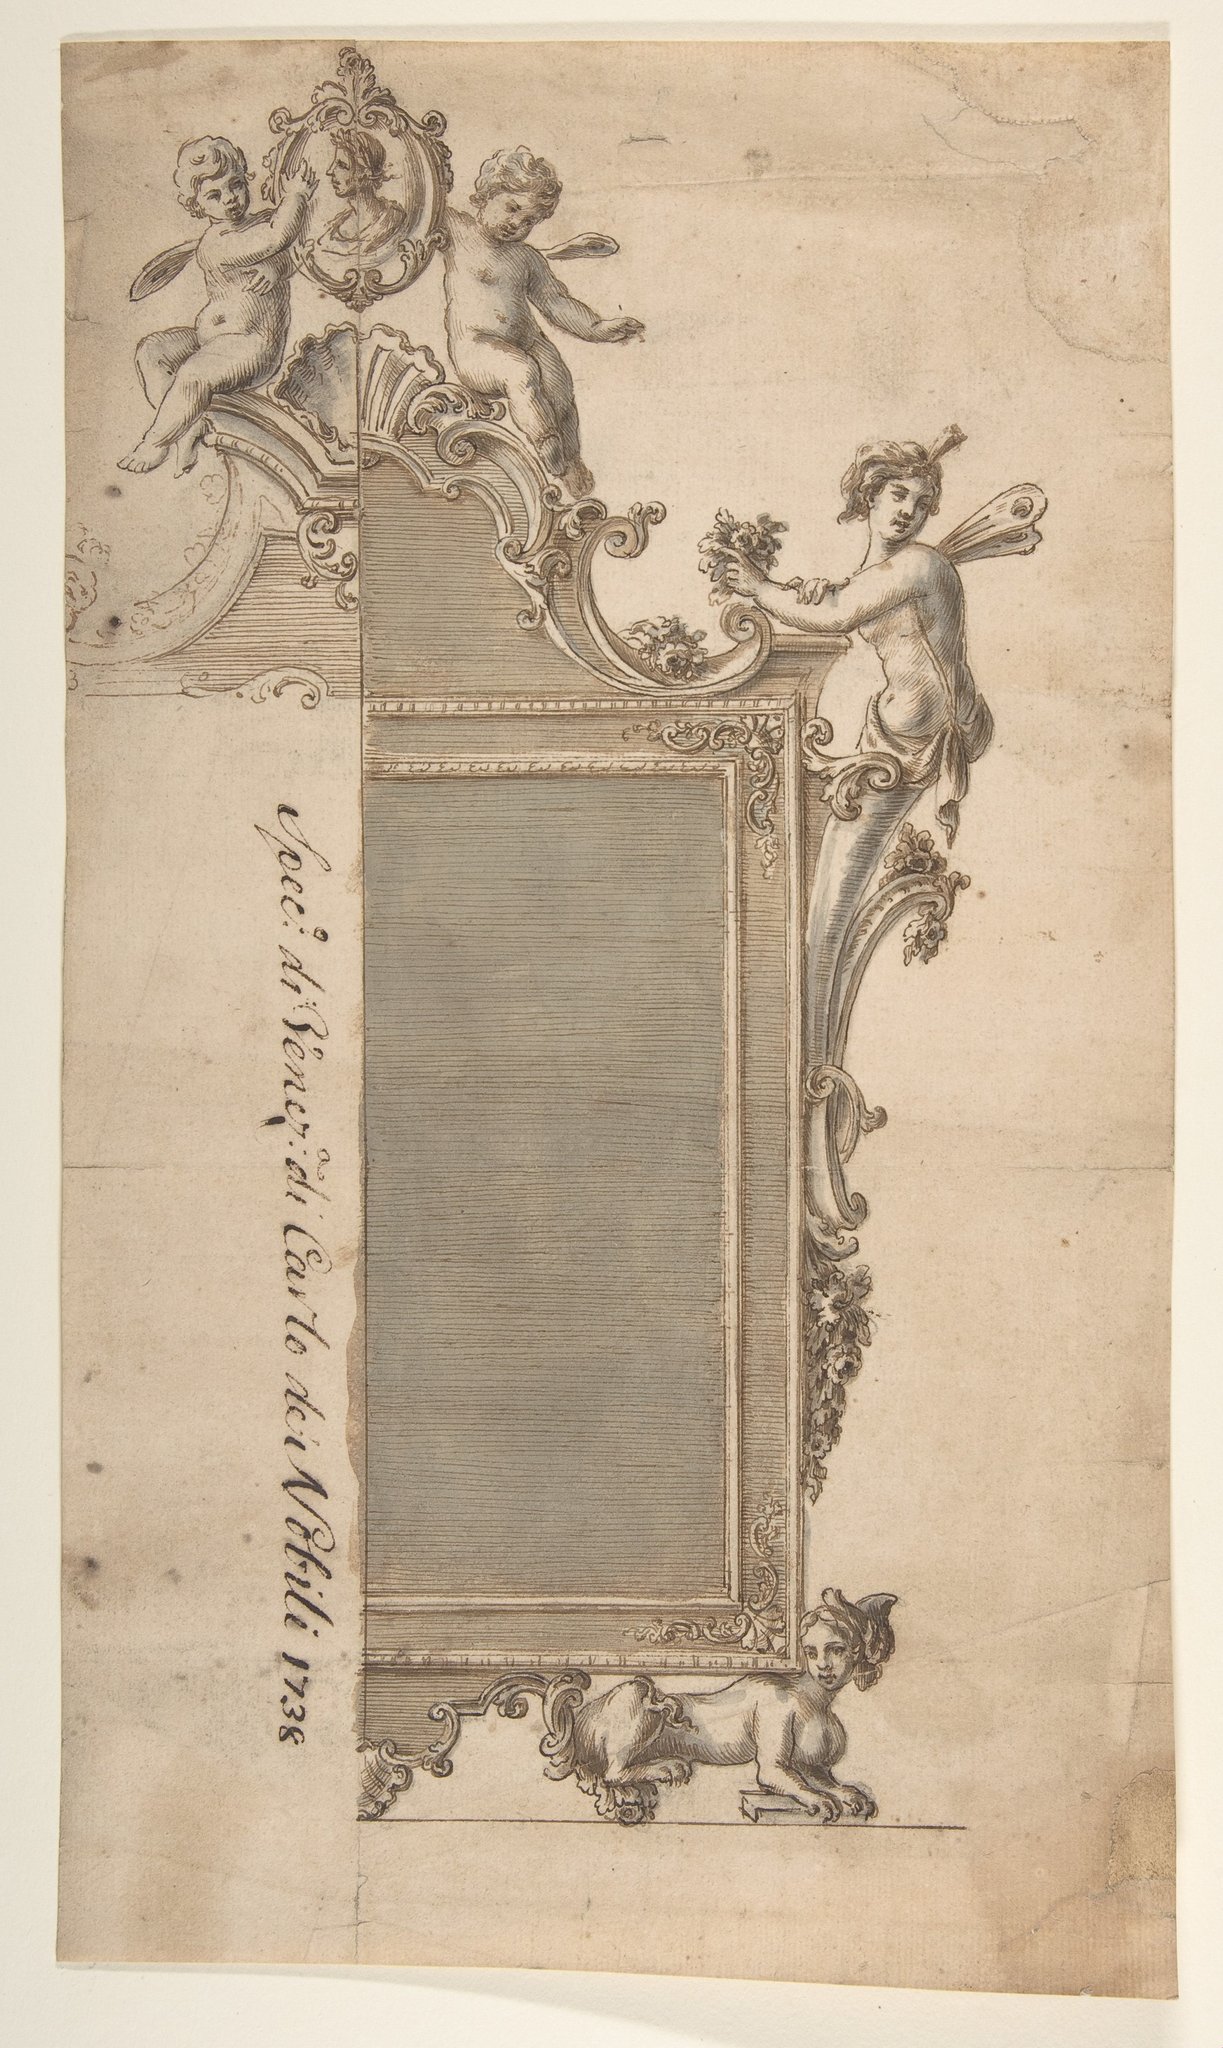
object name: drawing ornament architecture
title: Design for Mirror Frame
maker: giovanni battista natali iii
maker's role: artist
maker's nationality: italian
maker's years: 1698-1765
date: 1720-1740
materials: chalk, graphite, ink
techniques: brush, pen, wash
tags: mirrors